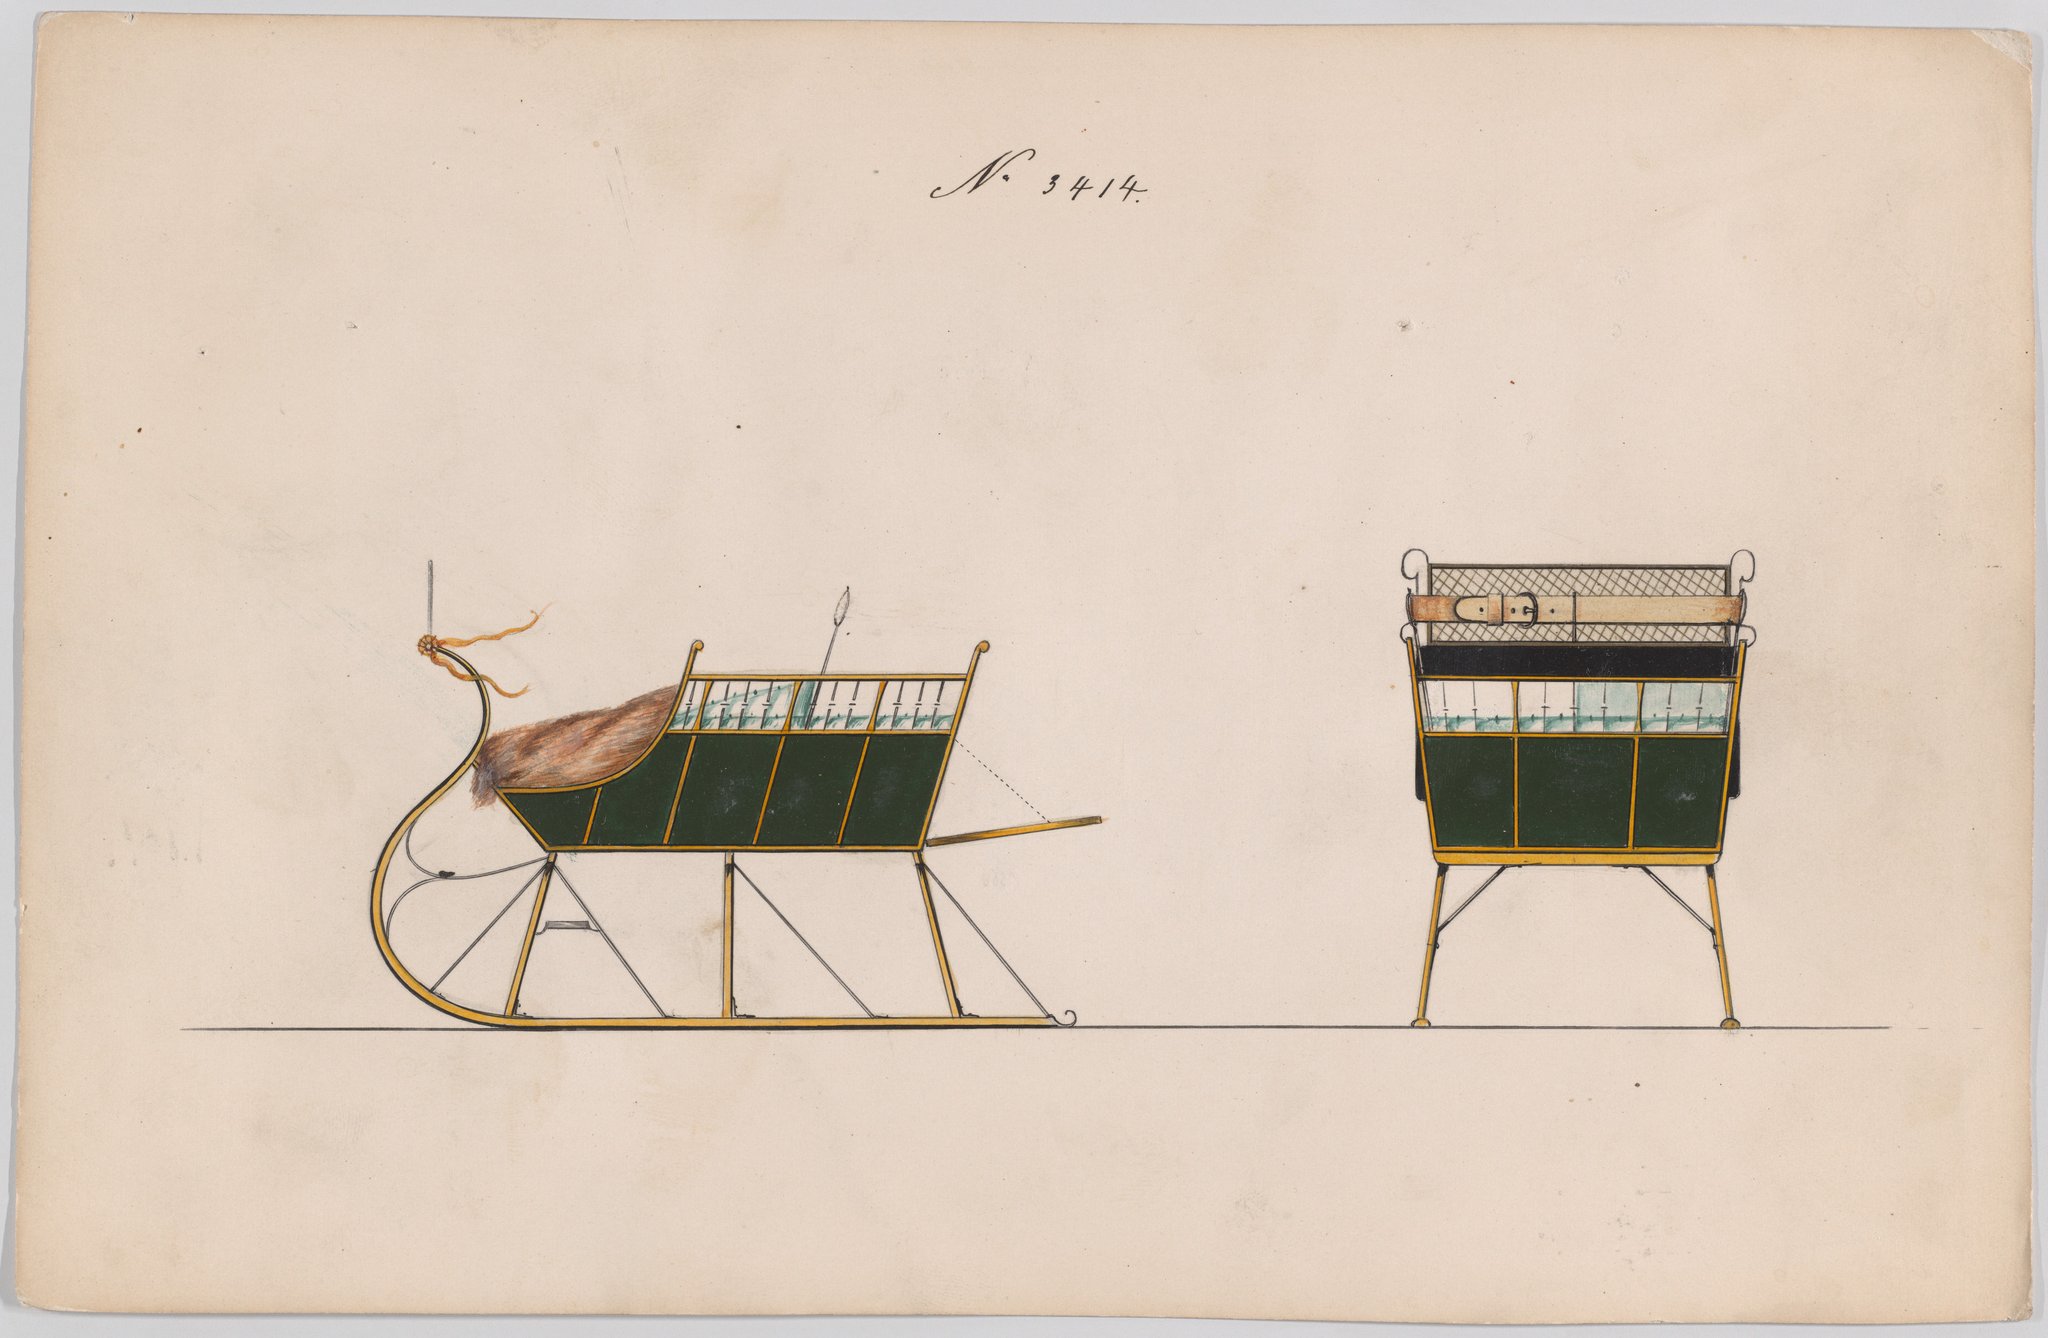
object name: drawing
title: Design for 4 Seat Sleigh, no. 3414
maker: brewster & co.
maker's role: manufacturer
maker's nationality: american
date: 1878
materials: gouache, gum arabic, ink, watercolor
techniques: pen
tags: sleighs